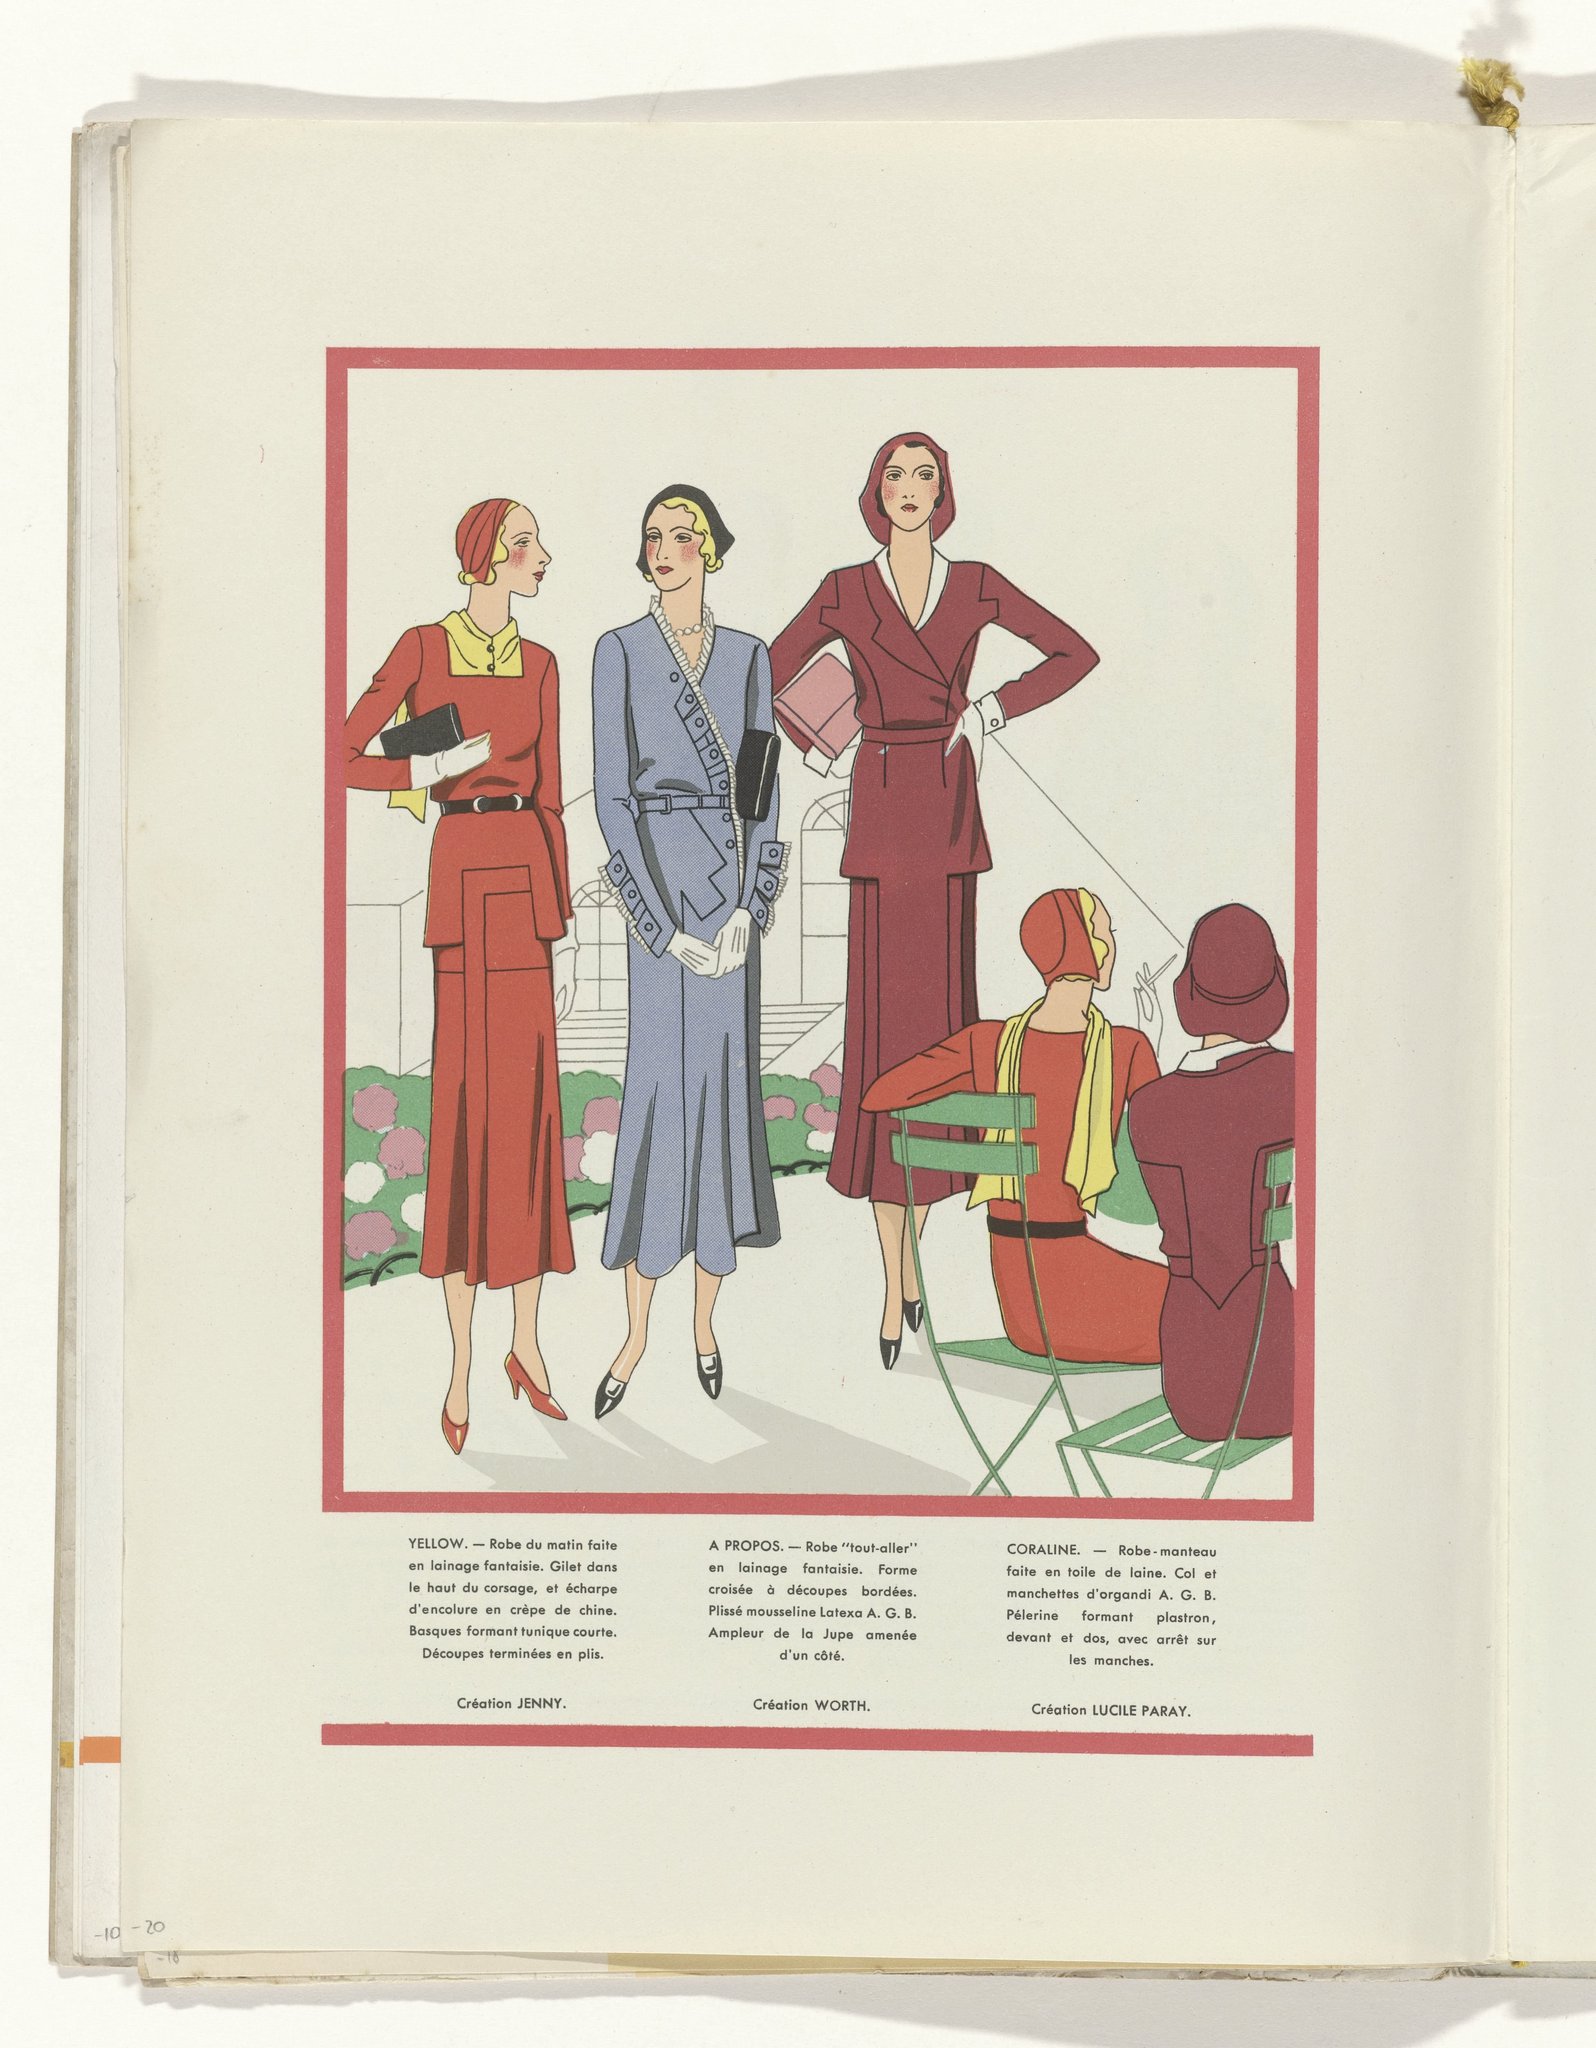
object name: magazine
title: Art - Goût - Beauté, Feuillets de l' élégance féminine, Mai 1931, No. 129, 11e Année, p. 20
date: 1931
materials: paper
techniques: printing, hand coloring, lithograph, photography, pochoir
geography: paris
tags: dress, gown: morning dress (+ women's clothes), bag (handbag) (+ women's clothes), dress, gown (robe manteau) (+ women's clothes), fashion plates, head-gear: hat (+ women's clothes)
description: Drie staande vrouwen in een tuin, van wie er ook twee zittend op de rug zijn weergegeven. Ochtendjapon van Jenny; japon voor elk moment van de dag van Worth en een robe-manteau van Lucille Paray. Pagina uit het modetijdschrift Art-Goût-Beauté (1920-1933).